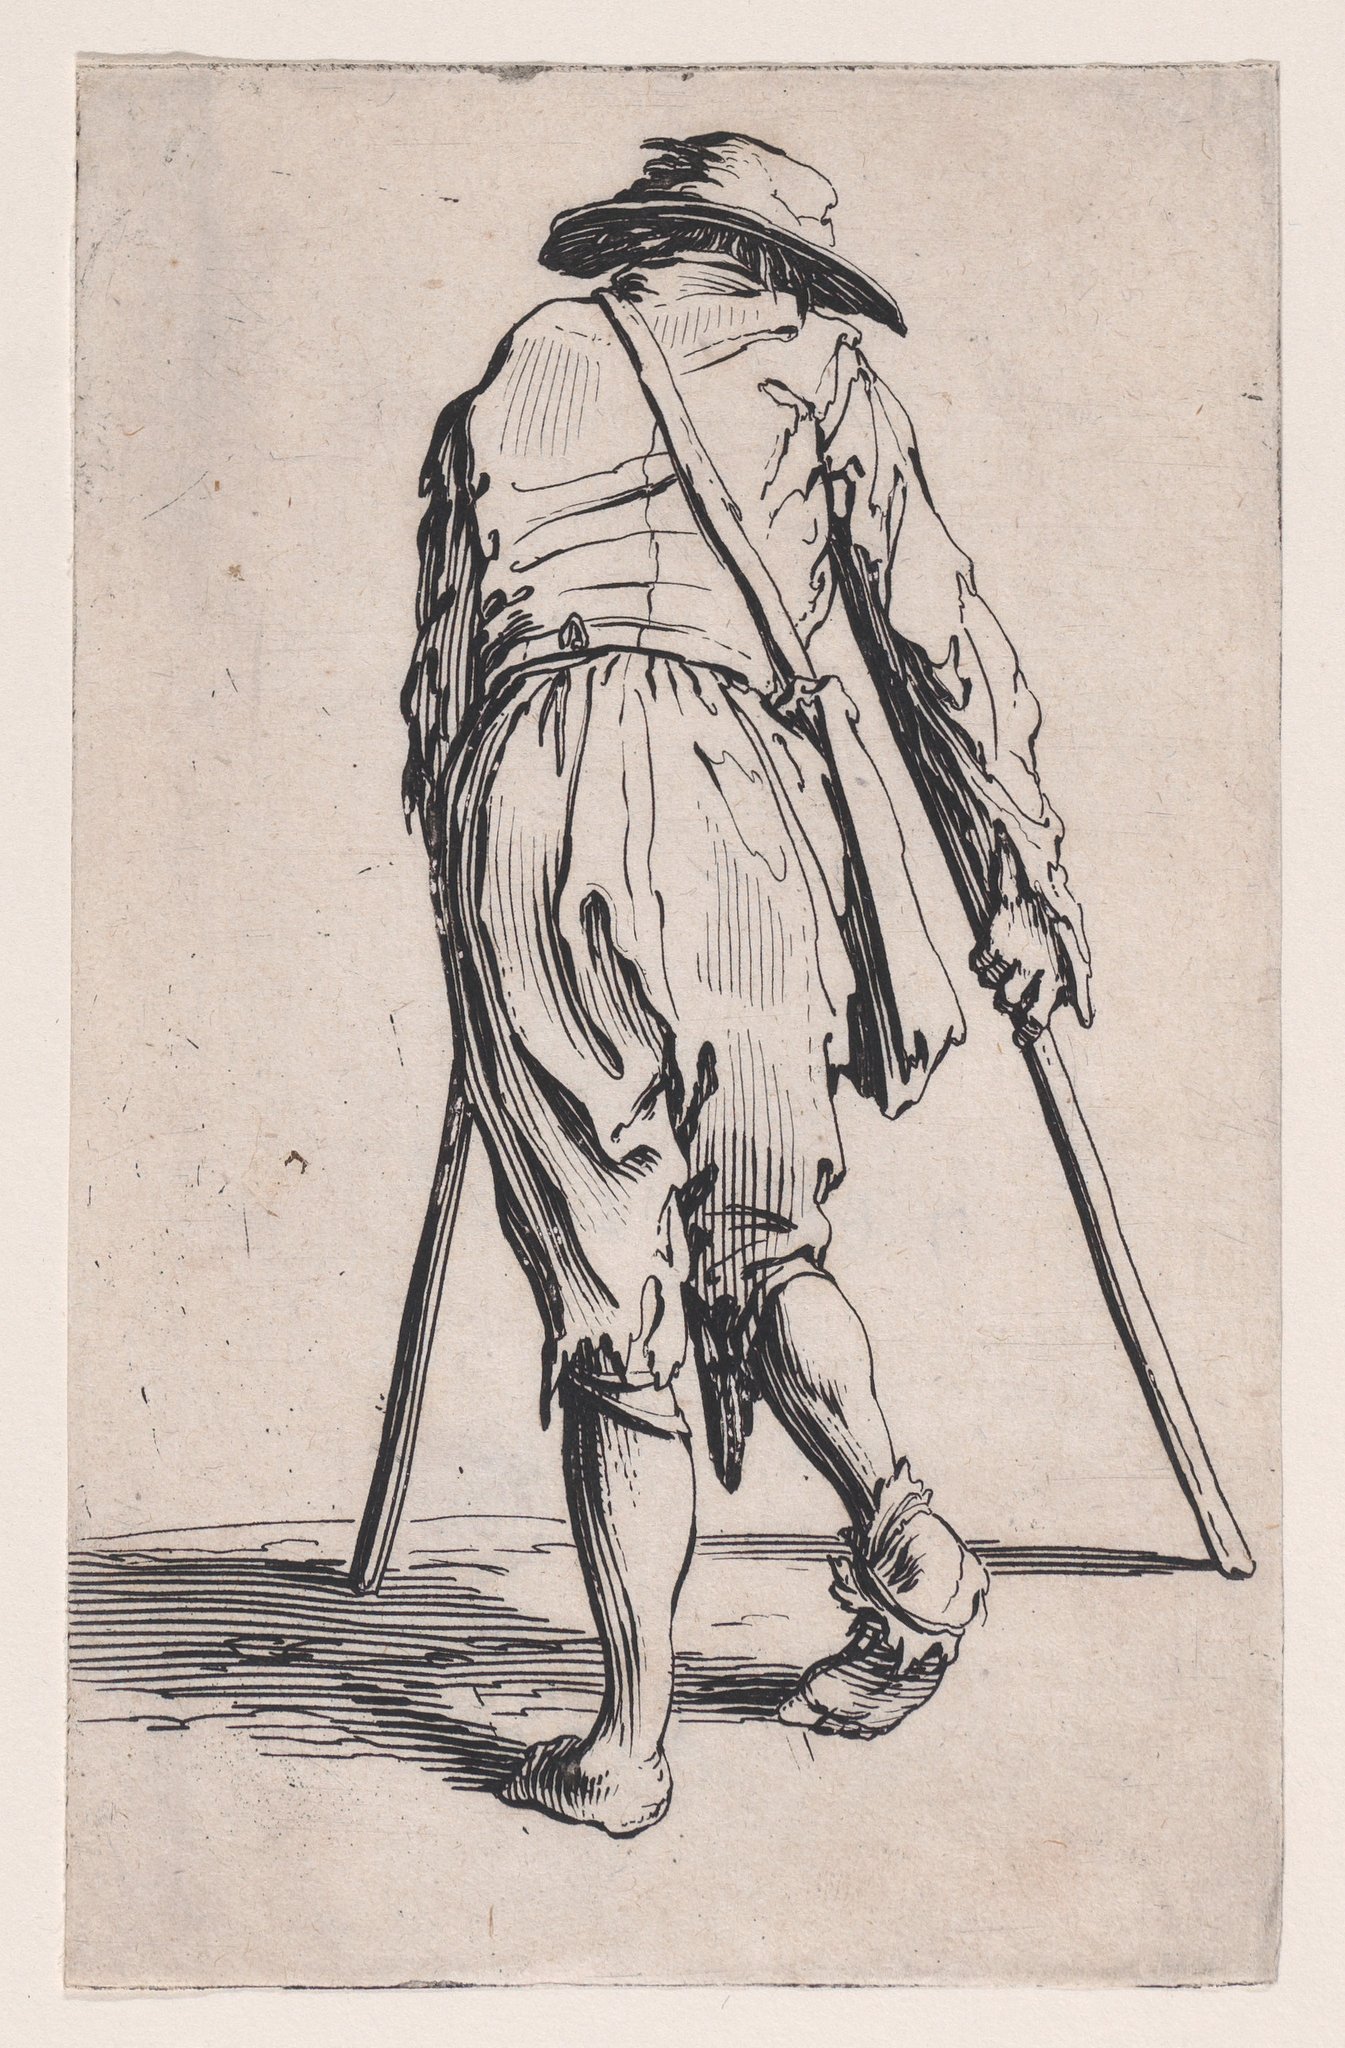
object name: print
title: Le Mendiant aux Béquilles Coiffé d'un Chapeau et Vu de Dos (The Beggar with Crutches and a Hat Viewed from Behind), from "Les Gueux suite appelée aussi Les Mendiants, Les Baroni, ou Les Barons" (The Beggars, also called the Barons)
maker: jacques callot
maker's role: artist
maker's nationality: french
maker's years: 1592-1635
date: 1623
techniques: etching